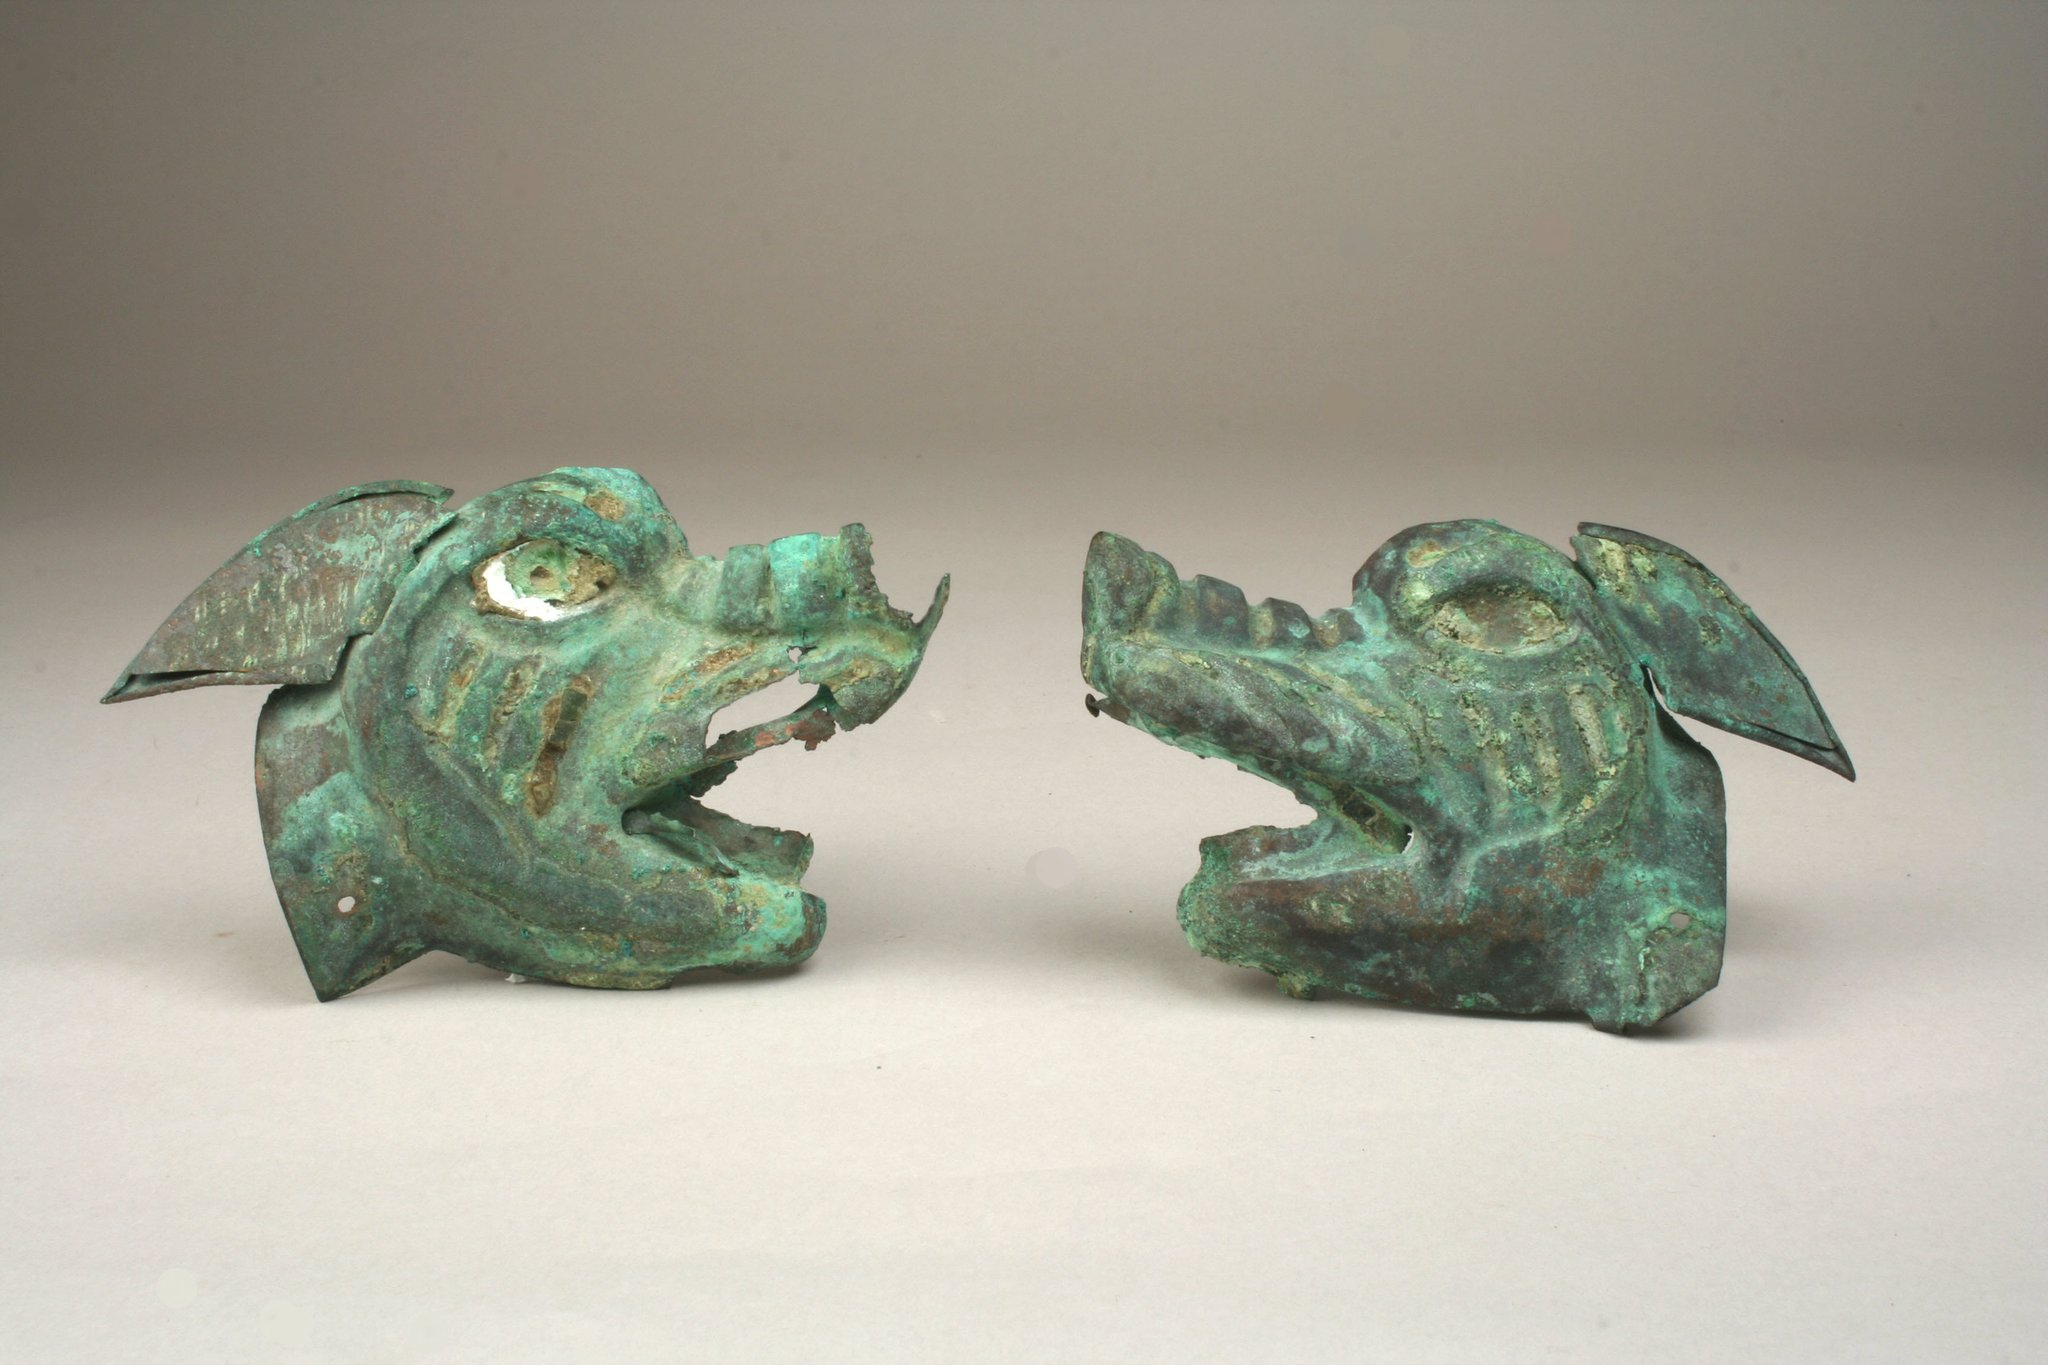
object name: ornament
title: Fox Head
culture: moche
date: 501-700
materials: copper, shell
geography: peru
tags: foxes